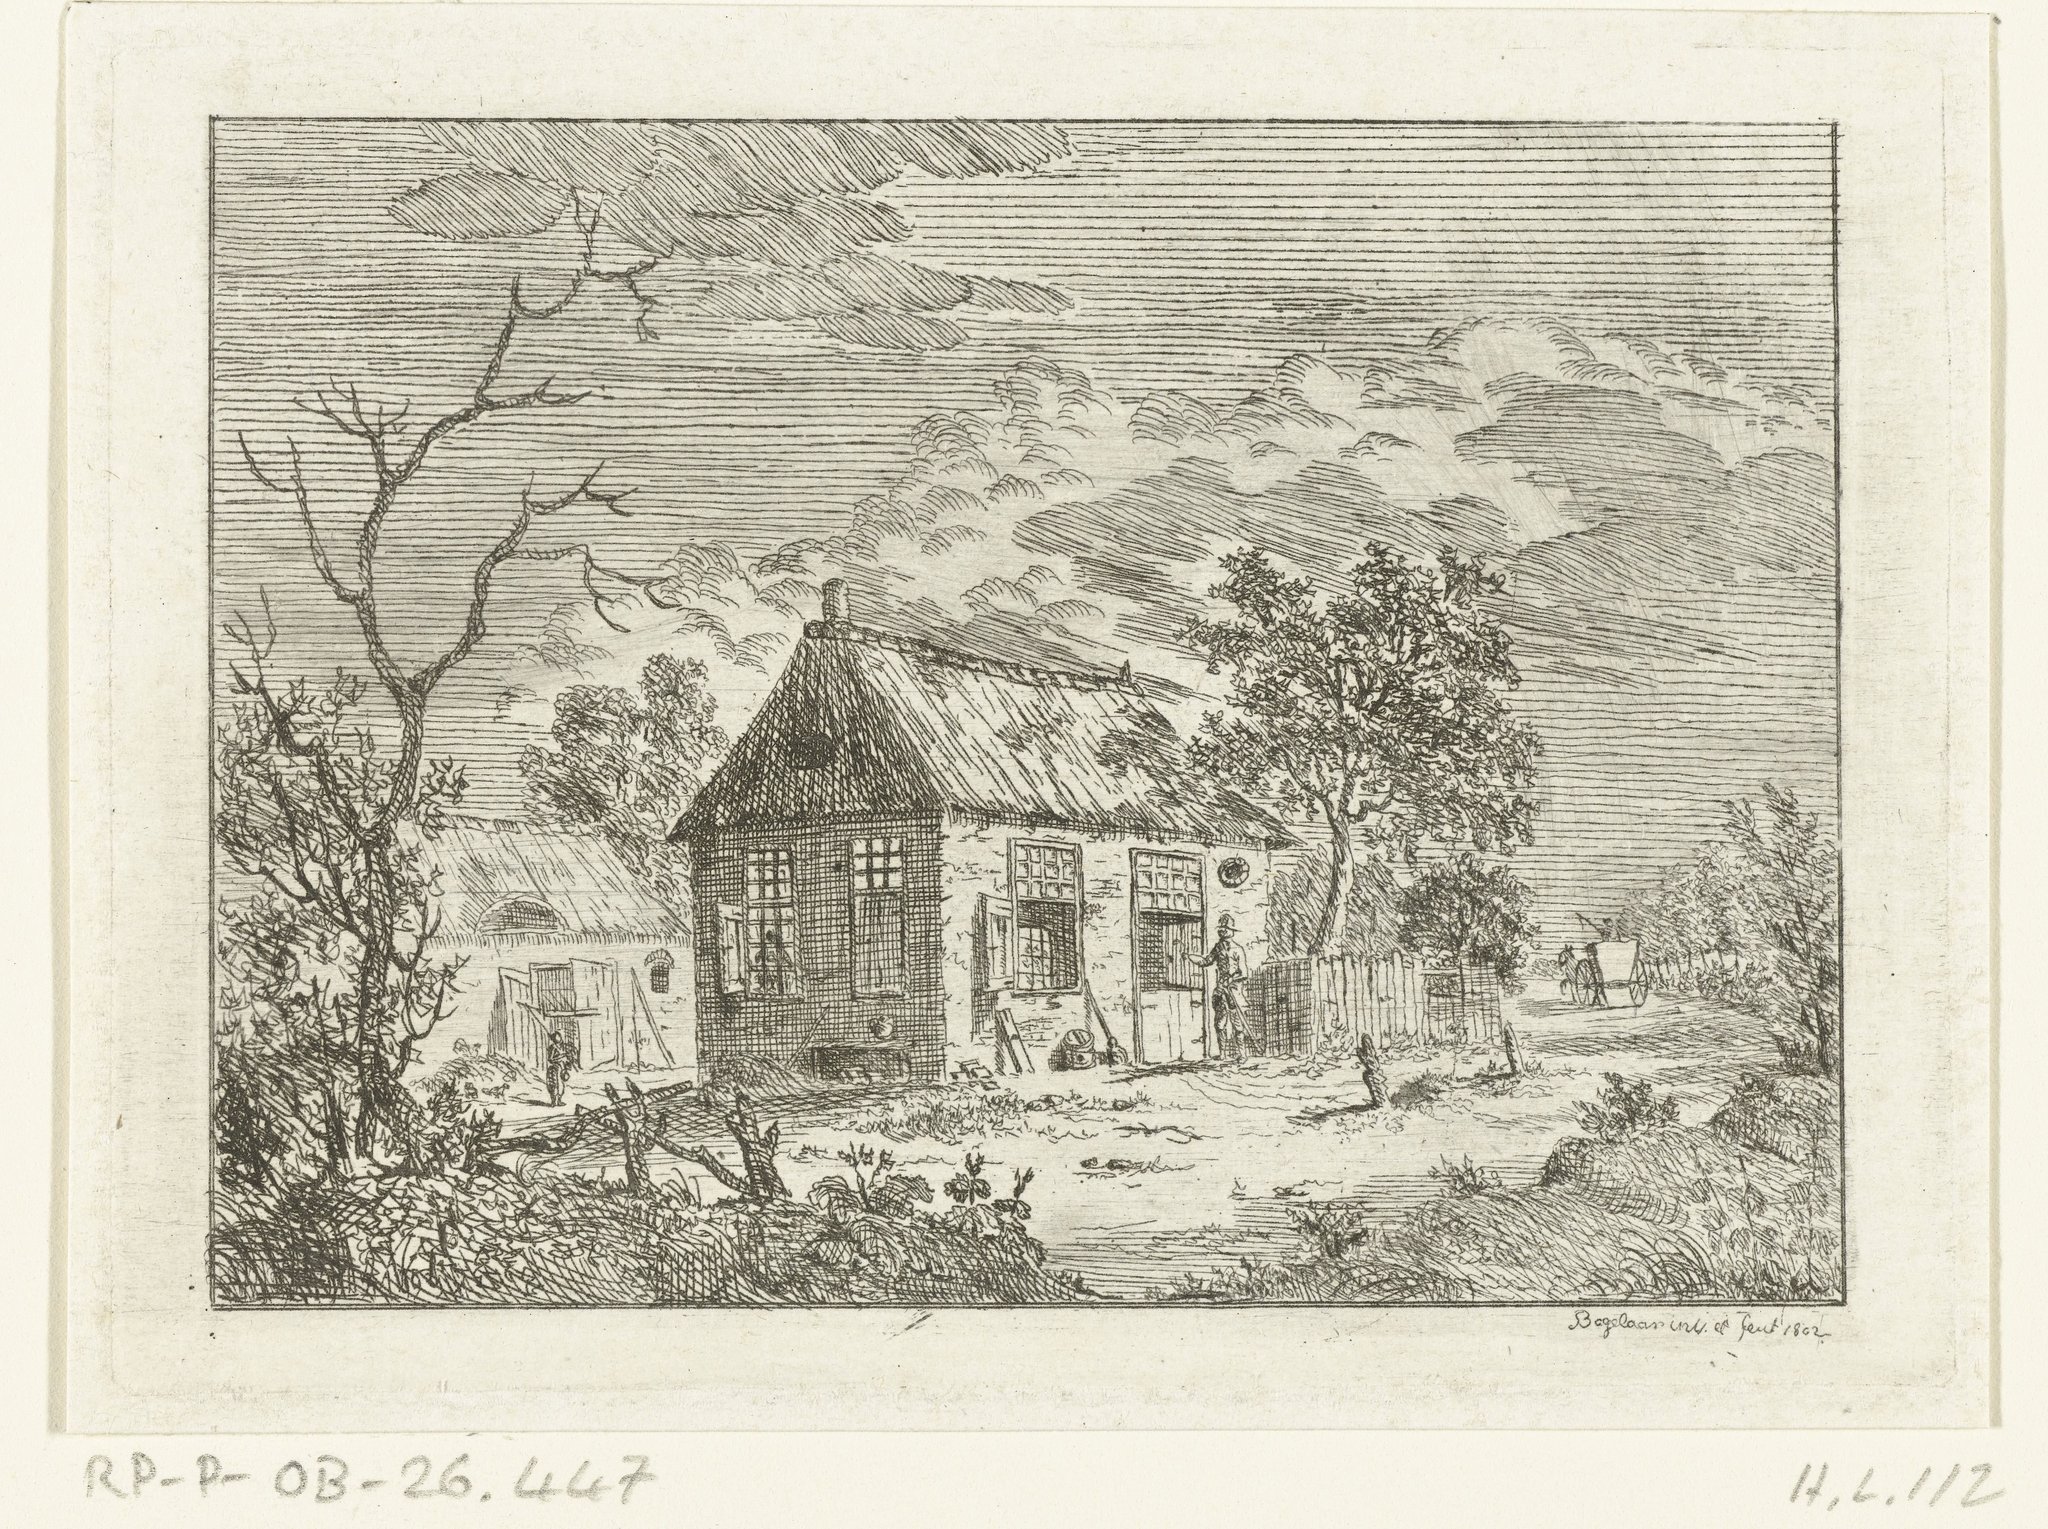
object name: print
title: Man voor de deur van een huis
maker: ernst willem jan bagelaar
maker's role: draughtsman, print maker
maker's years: 1775-1837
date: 1802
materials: paper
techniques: drypoint, etching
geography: netherlands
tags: rural housing, e.g. country-house, villa, cottage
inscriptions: collector's mark: Lugt 2228